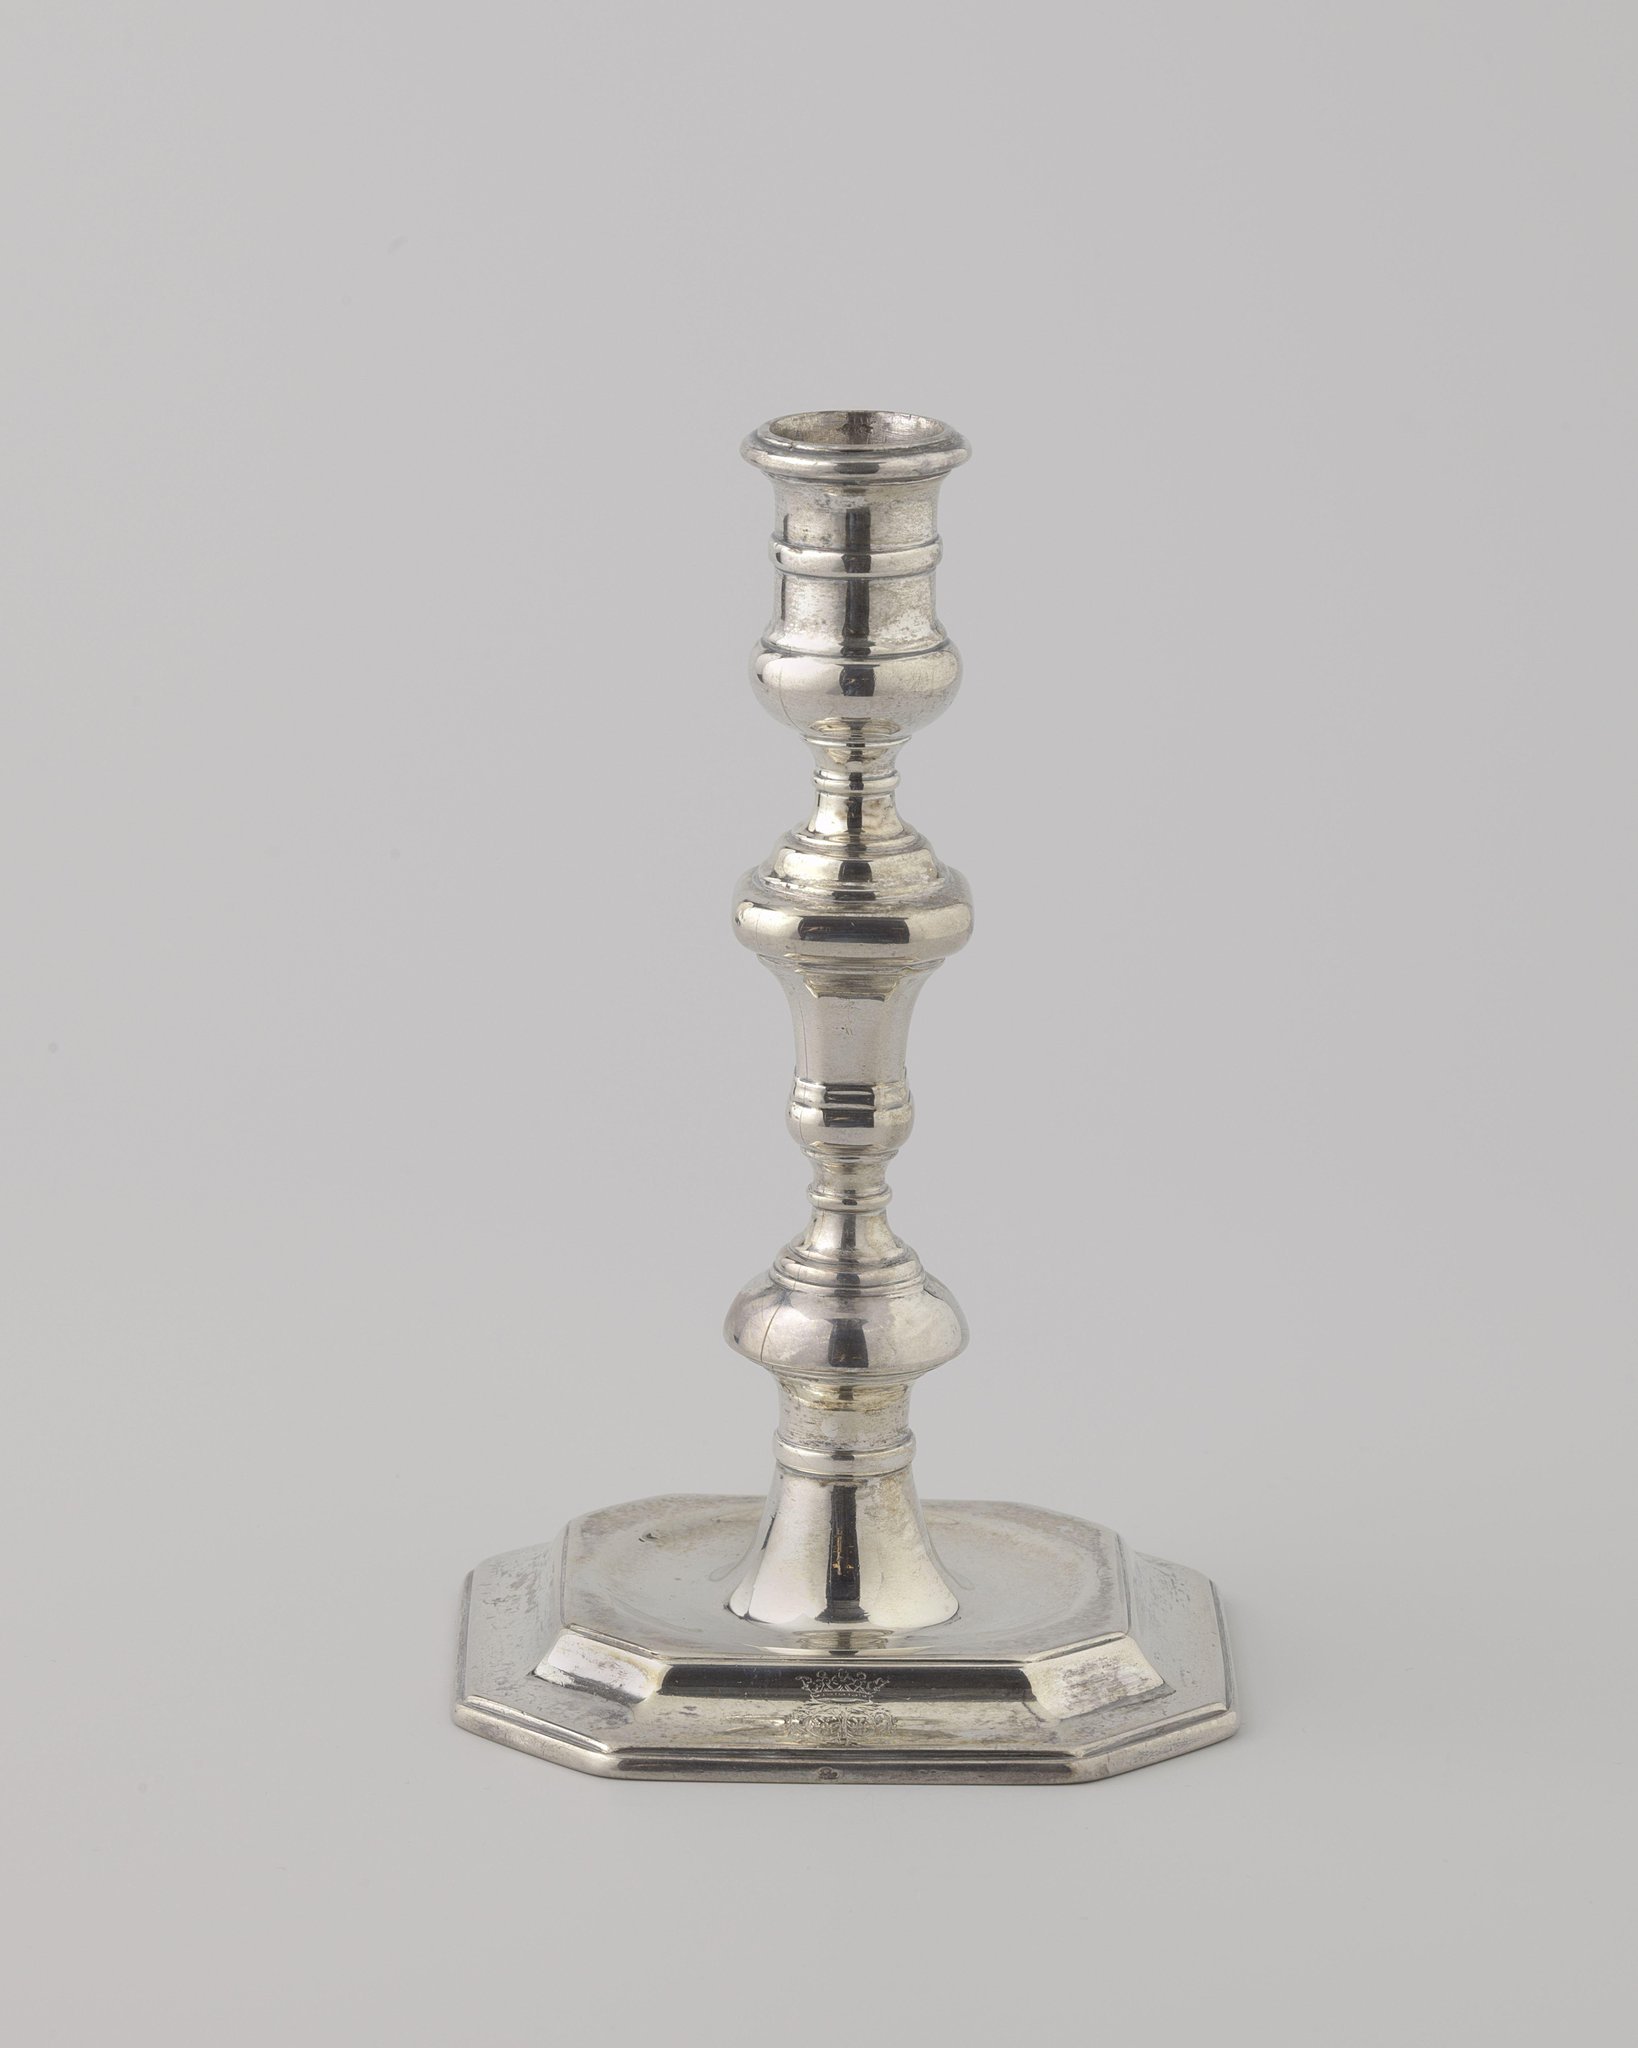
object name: candlestick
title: Kandelaar met op de voet een gegraveerd alliantiewapen, bestaande uit twee ovale schilden waarin een gekroonde tweekoppige adelaar met fleurons en klaverbladeren.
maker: Anonymous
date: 1709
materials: silver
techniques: casting, engraving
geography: the hague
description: Kandelaar bestaande uit een voet,een stam en een kaarsenhouder. Op de voet is een alliantiewapen gegraveerd, bestaande uit twee ovale schilden, ieder met een tweekoppige adelaar, gekroond met drie fleurons en twee klaverbladeren. Gemerkt en gedateerd.